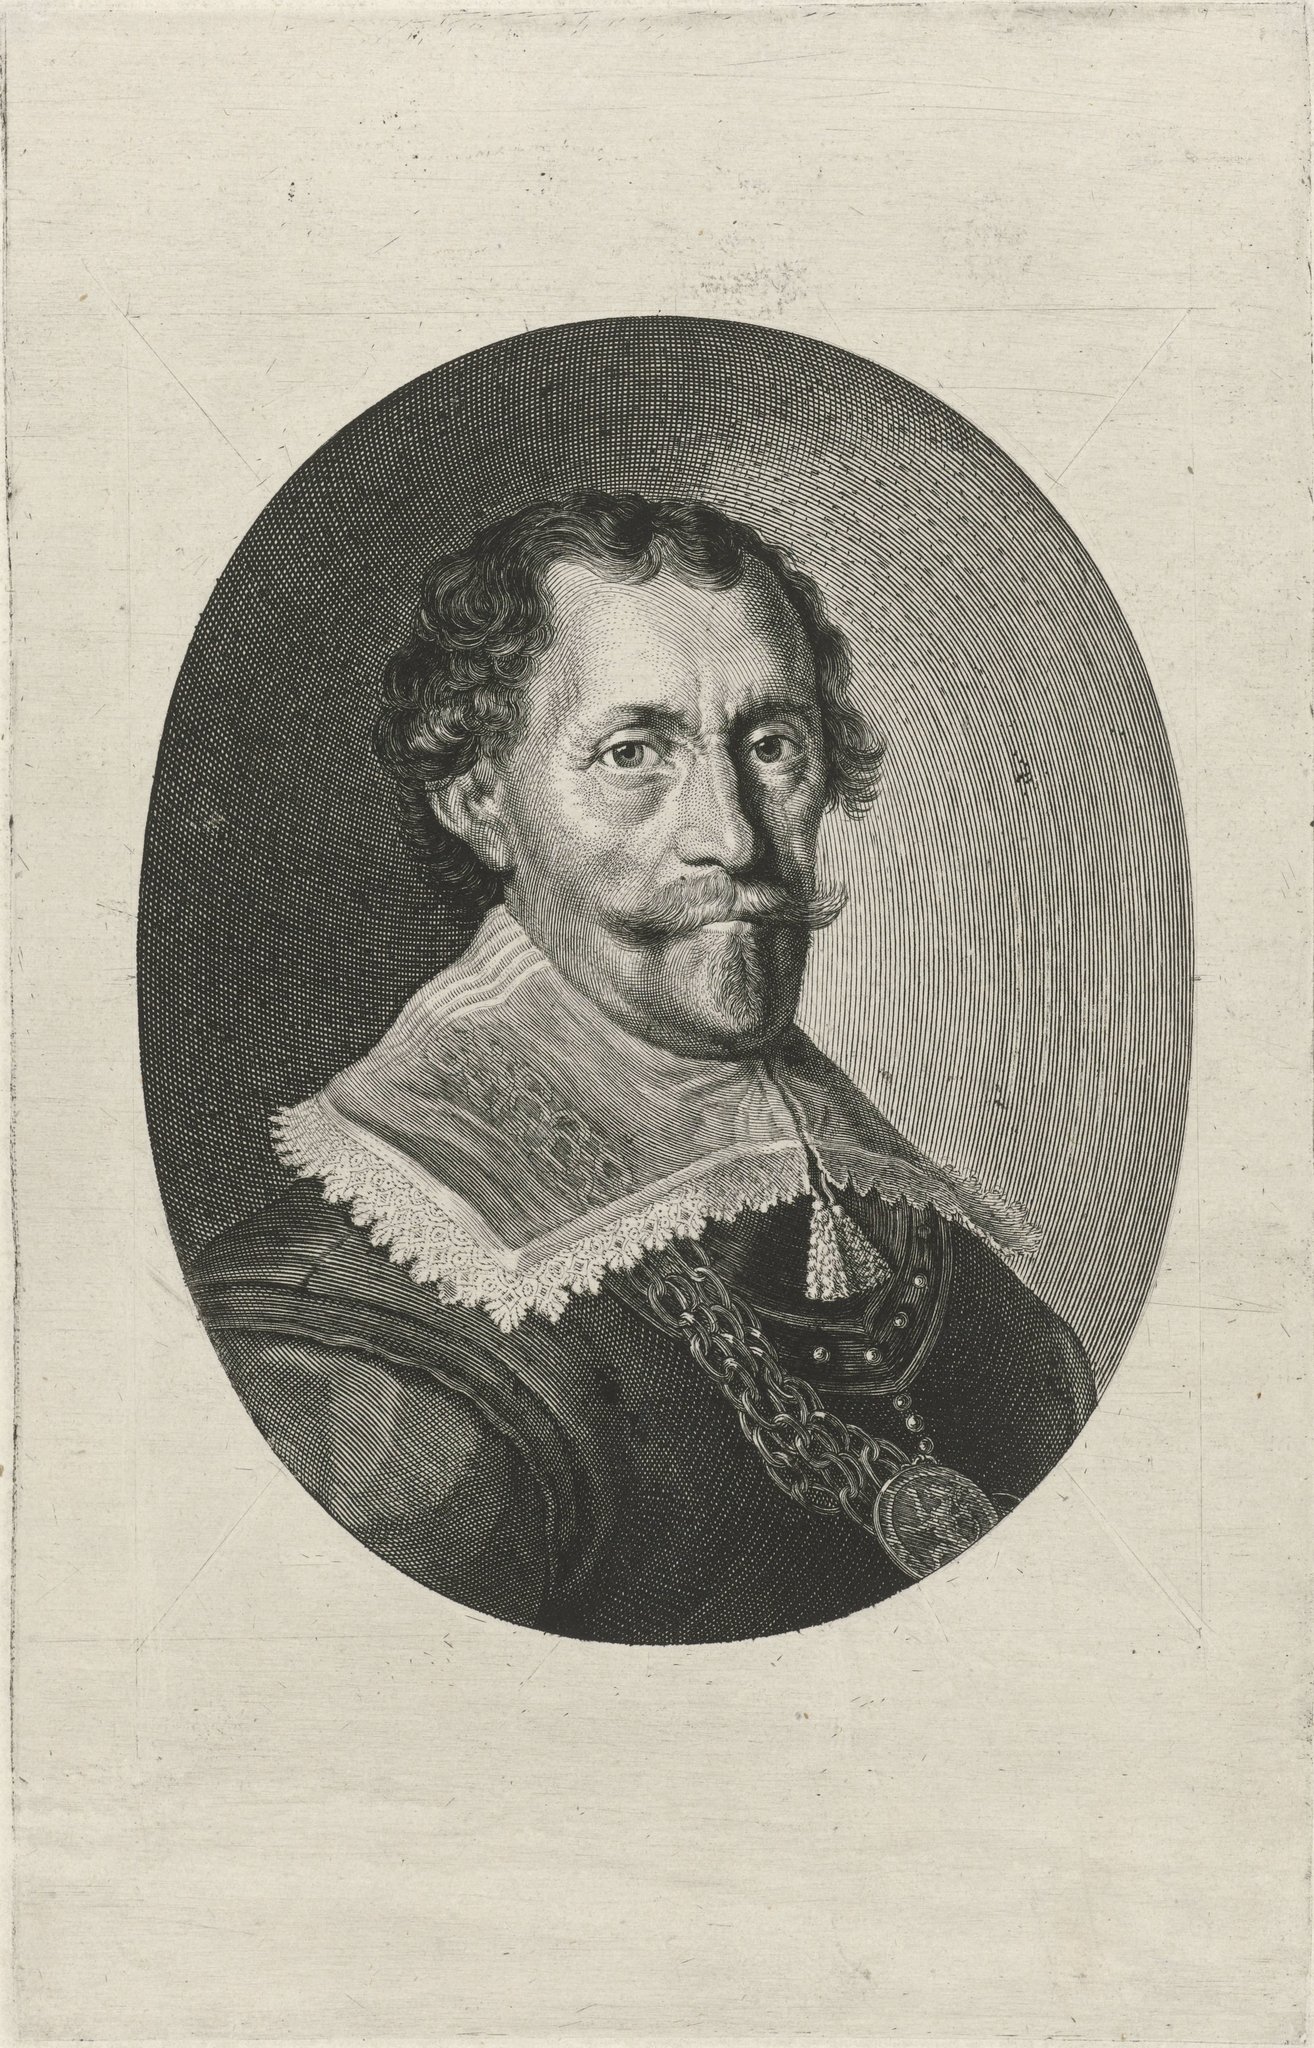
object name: print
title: Portret van Witte Cornelisz. de With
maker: theodor matham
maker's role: draughtsman, print maker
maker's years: 1605-1676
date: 1637-1641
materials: paper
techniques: engraving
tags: hoogendijk, zeeofficier, witte cornelisz. de with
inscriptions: collector's mark: Lugt 2228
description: Portret van de Witte Cornelisz. de With, vice-admiraal van Holland en West-Friesland.